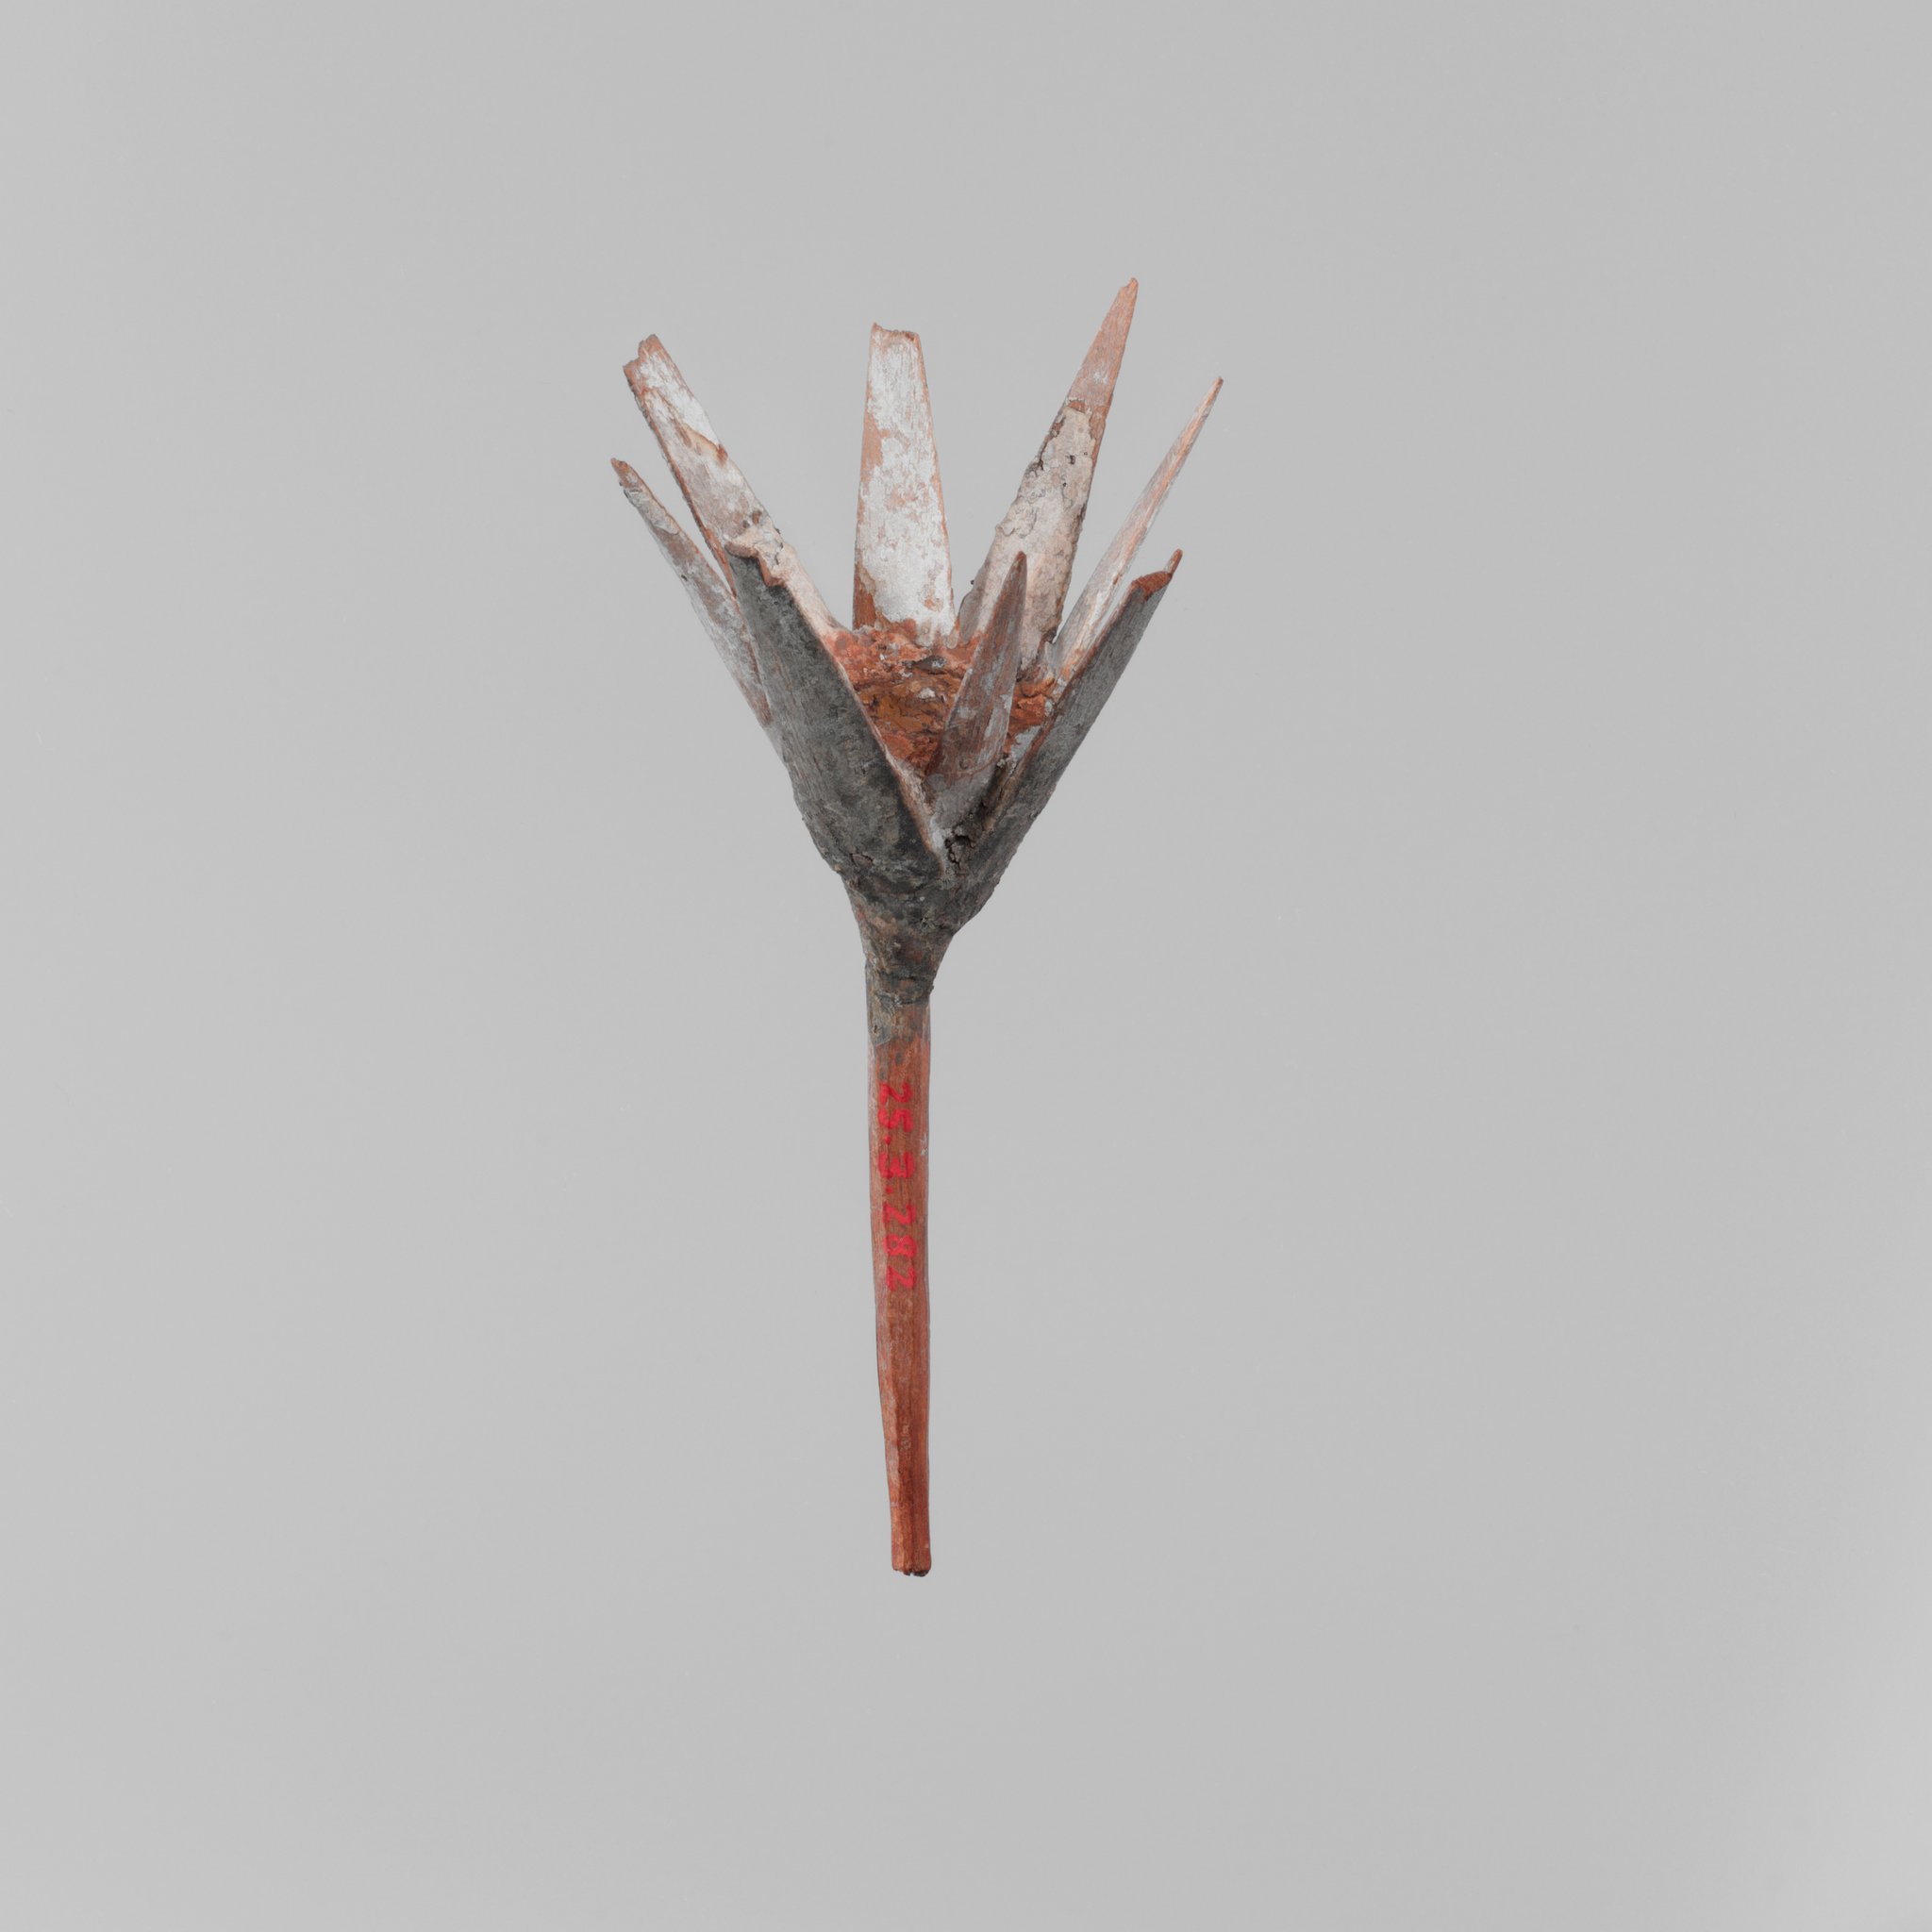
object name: model water lily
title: Model Lotus Flower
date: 2051-1981 BCE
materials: wood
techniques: painting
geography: egypt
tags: lotuses